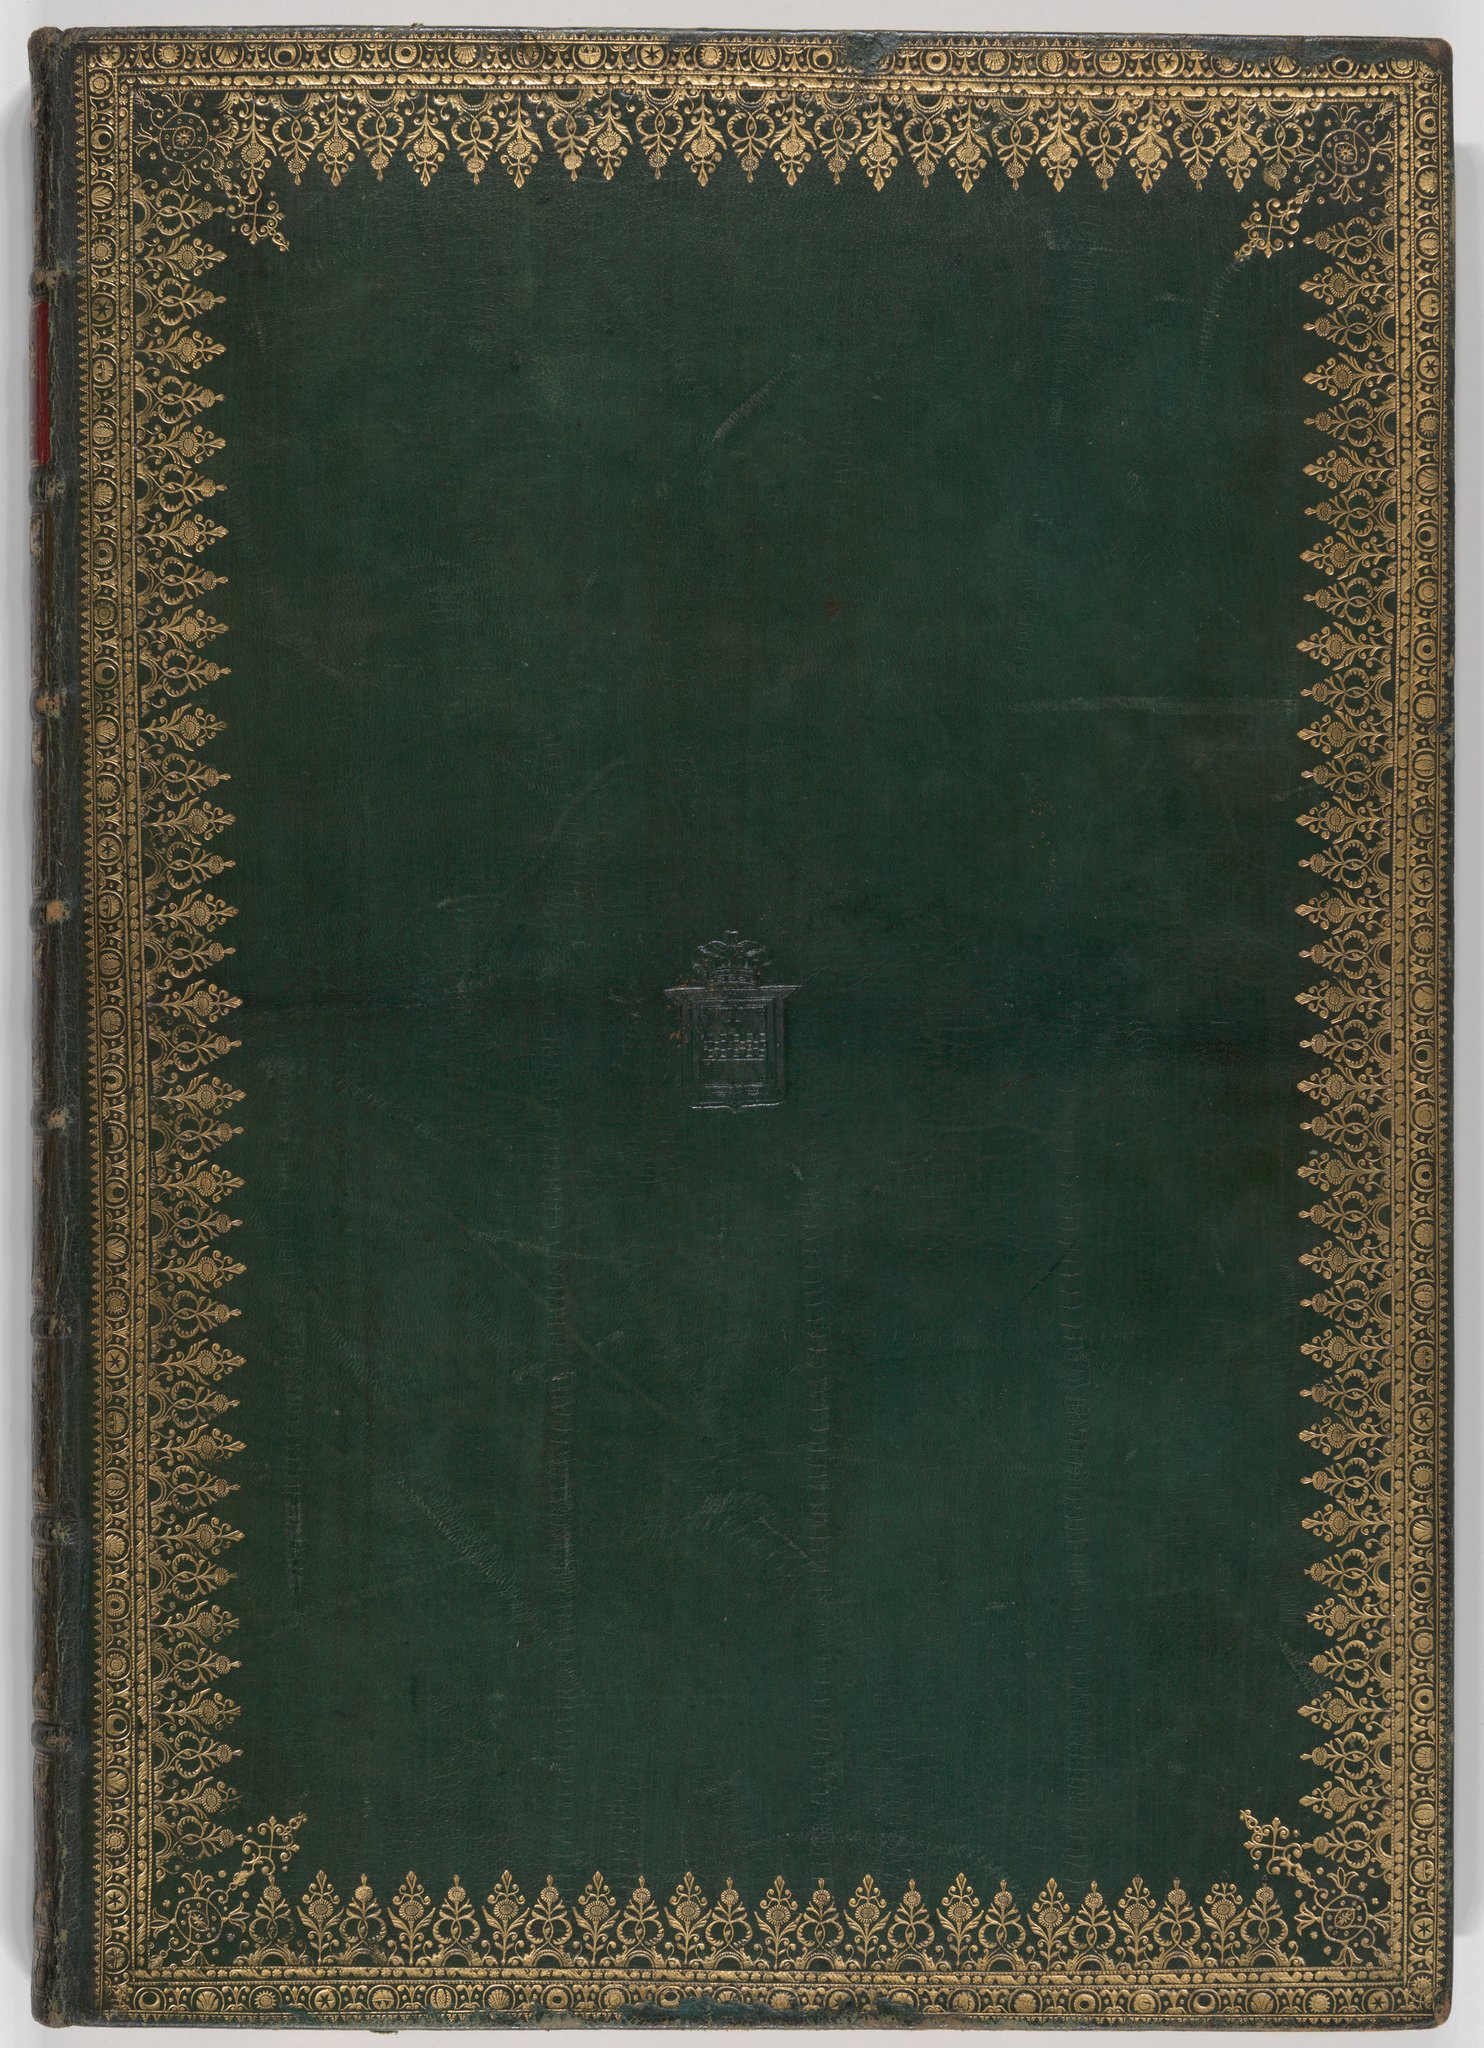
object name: album print ornament architecture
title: Plans, Elevations, Sections, and Perspective Views of the Gardens and Buildings of Kew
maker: sir william chambers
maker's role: architect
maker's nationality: british, born sweden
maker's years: 1723-1796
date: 1763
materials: gouache, ink, watercolor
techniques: brush, pen, wash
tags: leaves,coat of arms